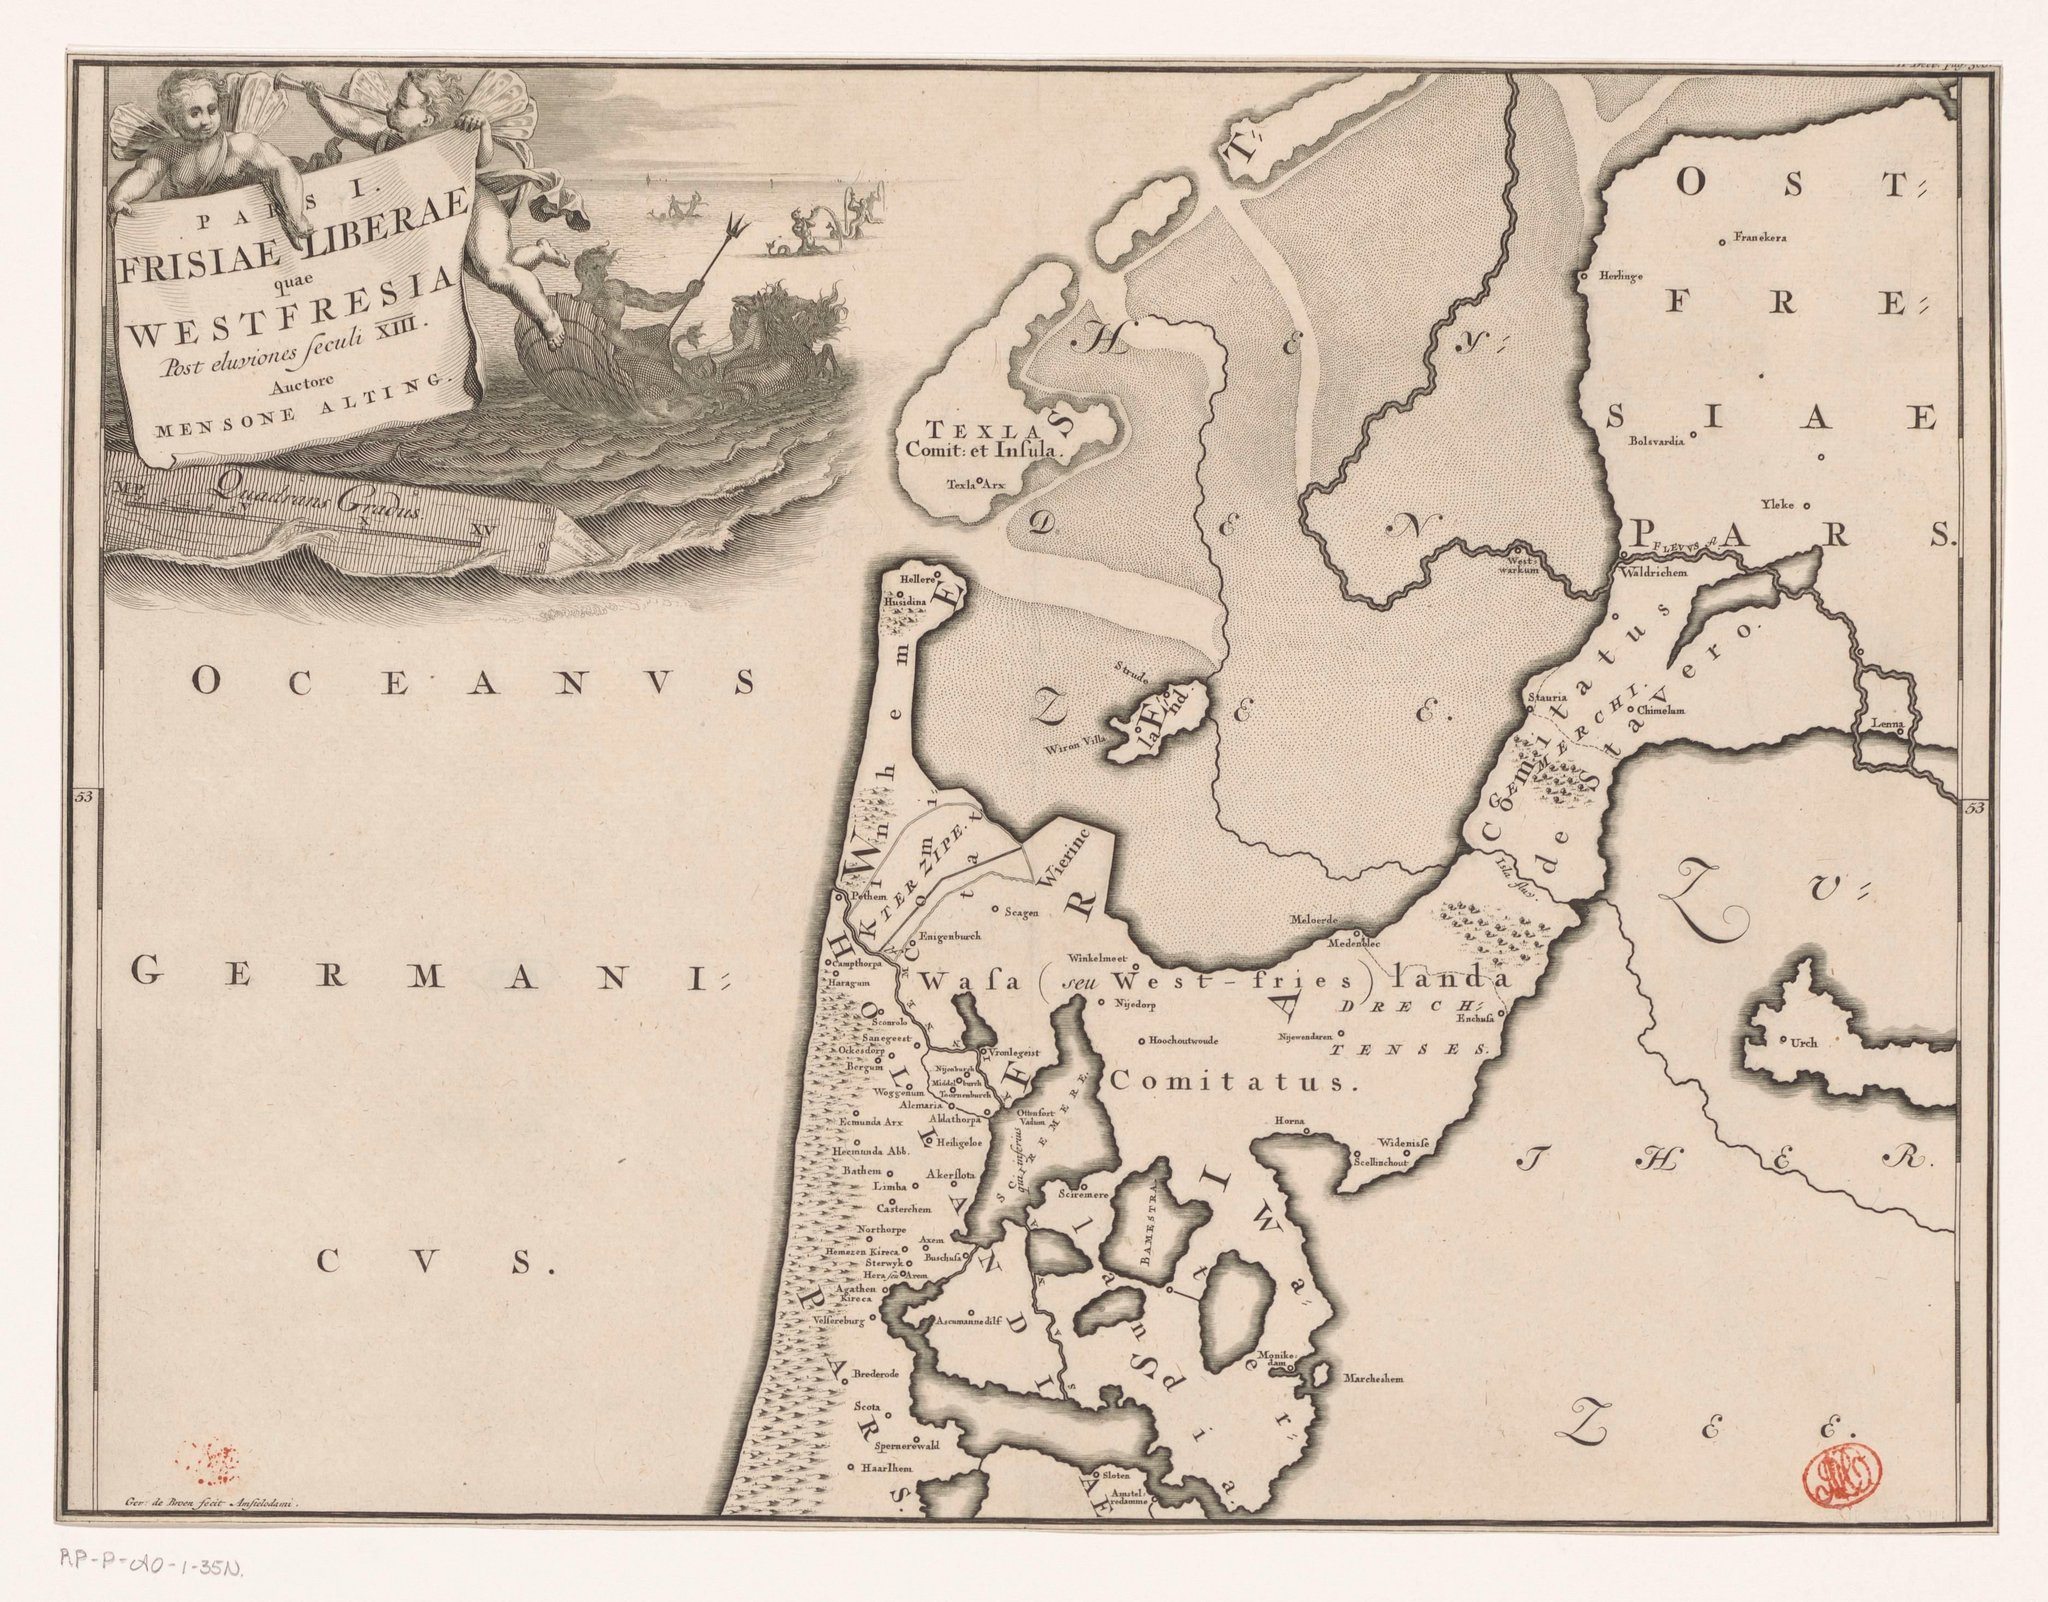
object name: print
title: Pars I Frisiae Liberae quae Westfresia (...)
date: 1697-1700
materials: paper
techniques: engraving, etching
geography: amsterdam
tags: (story of) neptune (poseidon), triton(s), maps of separate countries or regions, netherlands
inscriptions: collector's mark: Lugt 2228, collector's mark: Lugt 195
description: Maakt deel uit van 16 kaarten van het land van de Bataven en de Friezen eerst vervaardigd voor en opgenomen in Alting, Menso. Descriptio, secundum antiquos, agri Batavi & Frisii. 2 delen. Amsterdam: Henricus Wetstein, 1697-1700. Hergebruikt in Halma, François. Tooneel der Vereenigde Nederlanden, en onderhorige landschappen (...). 2 delen. Leeuwarden: Hendrik Halma, 1725. Deze kaart is gebruikt in Halma's Tooneel der Vereenigde Nederlanden (1725) en is waarschijnlijk te vinden in deel 2, p. 308.